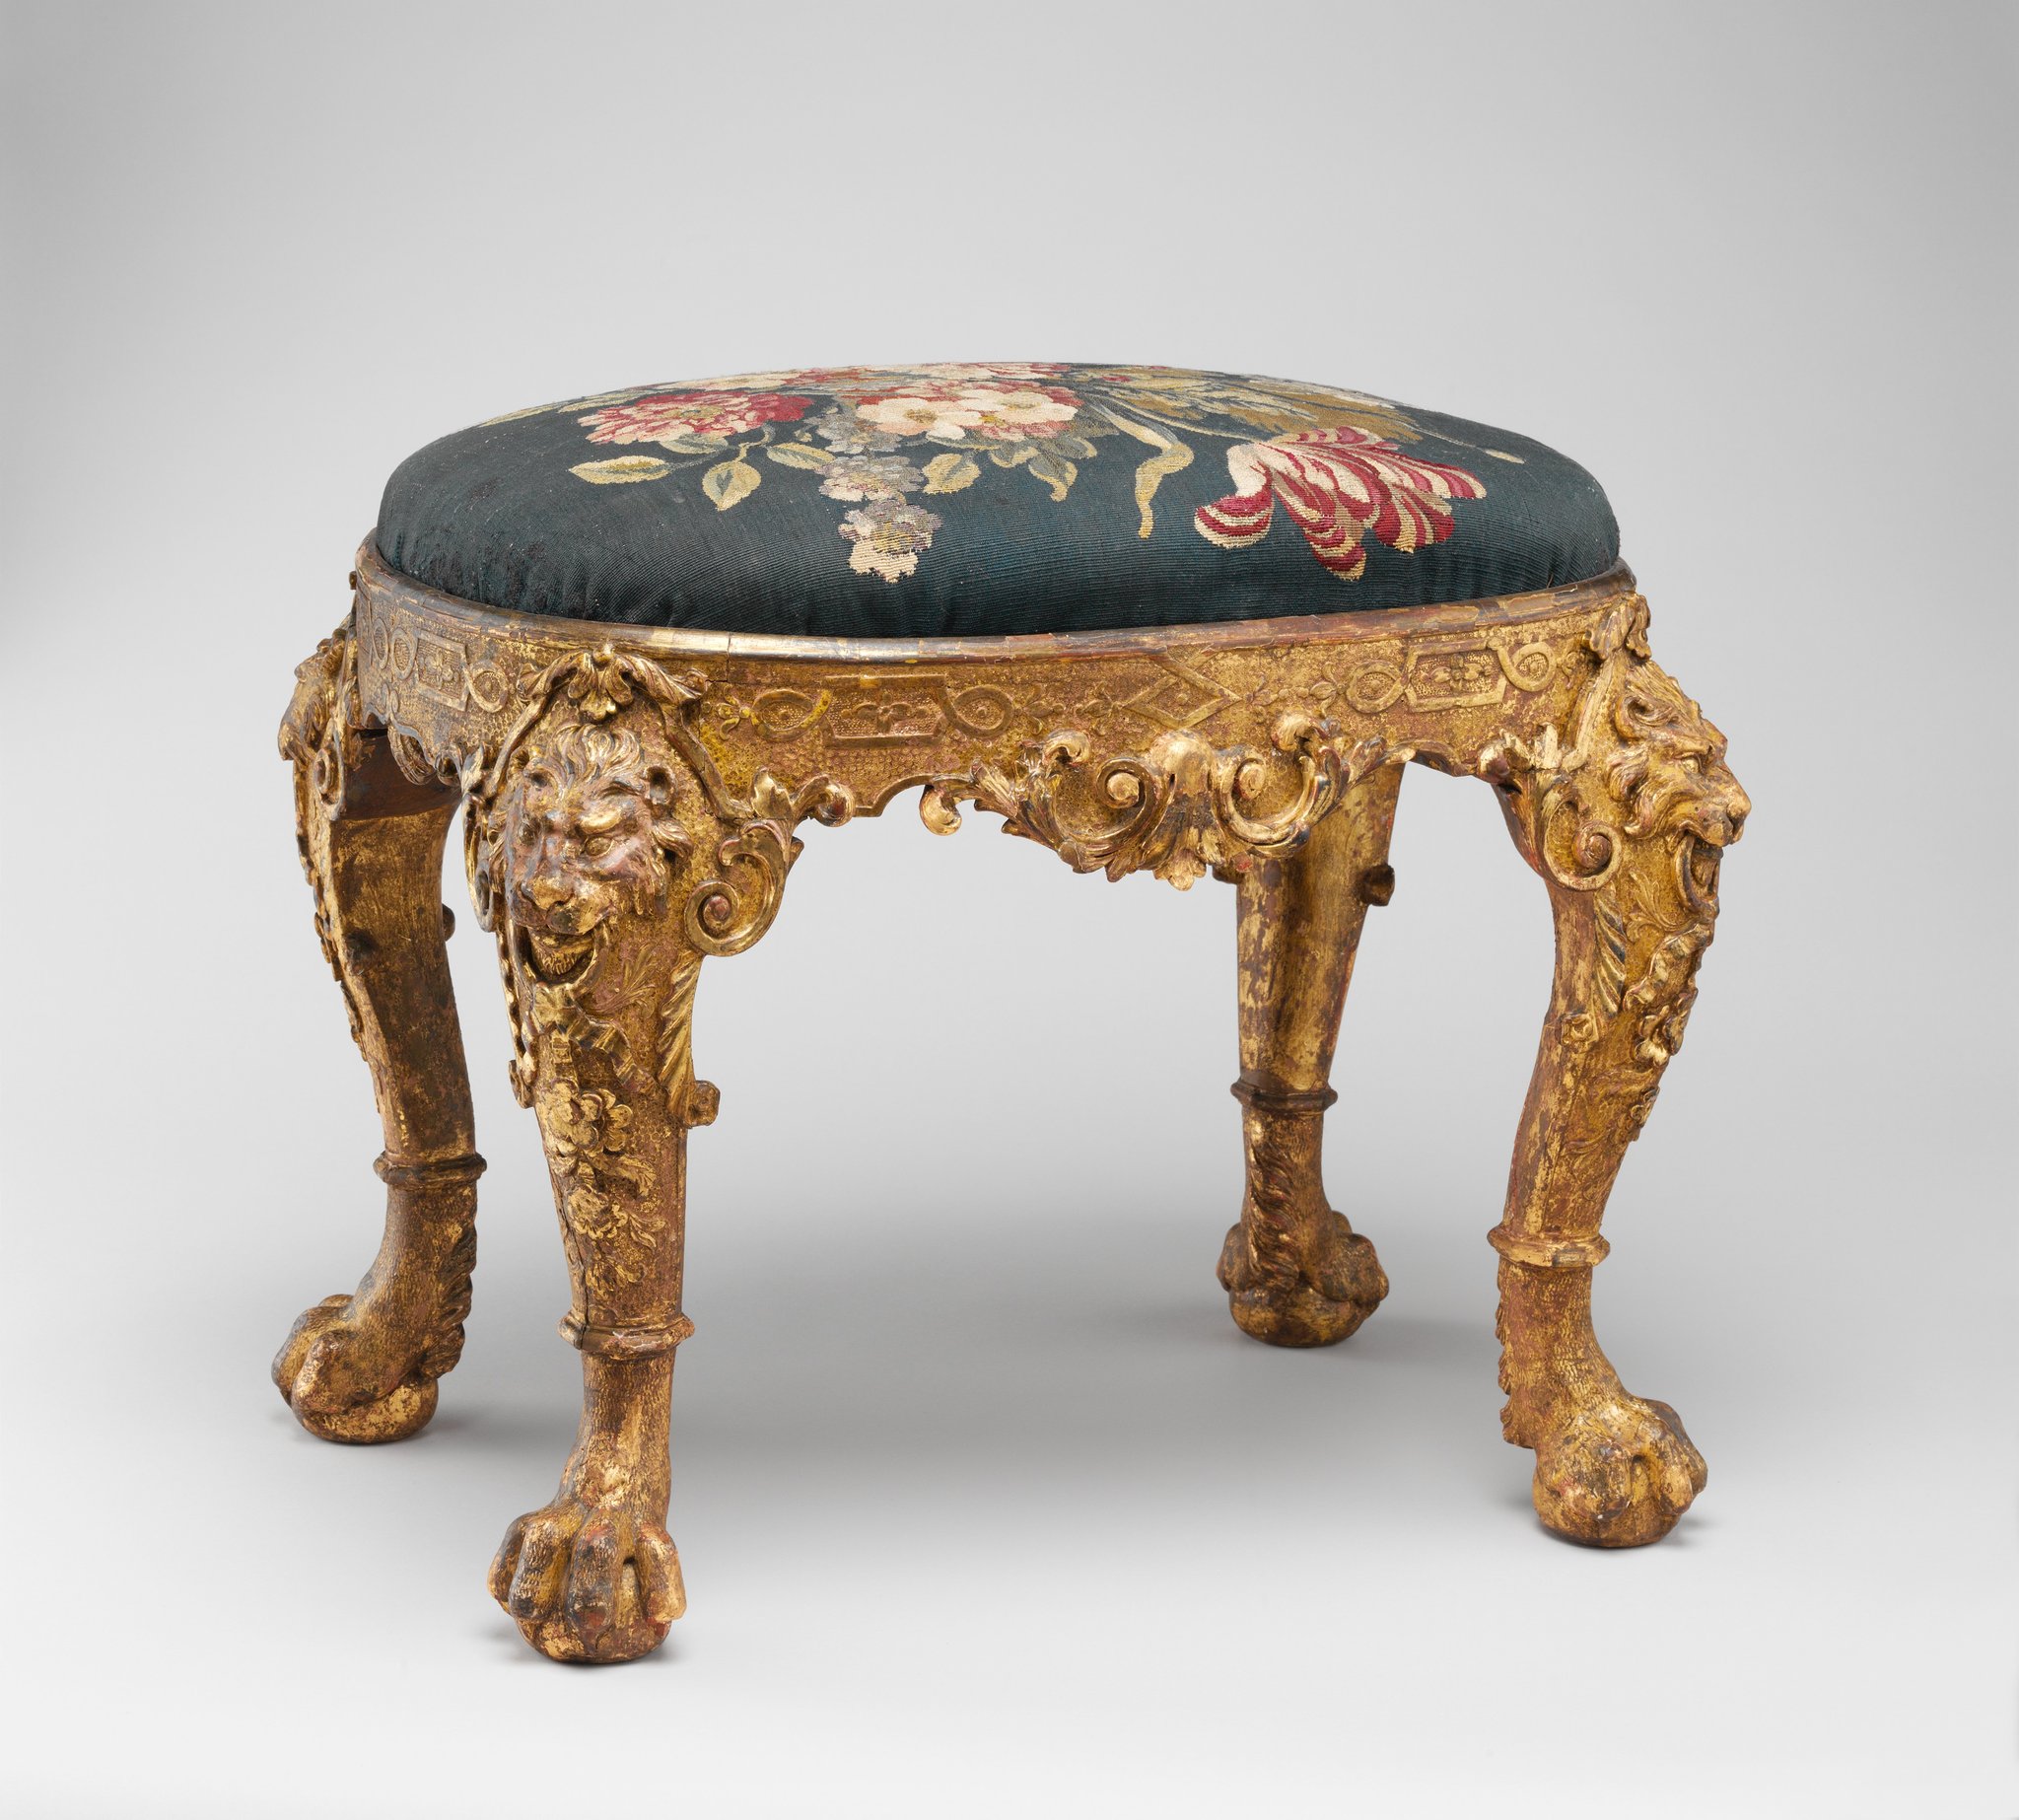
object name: stool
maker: soho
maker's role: factory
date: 1725-1735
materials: gesso, silk, wood, wool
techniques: gilding